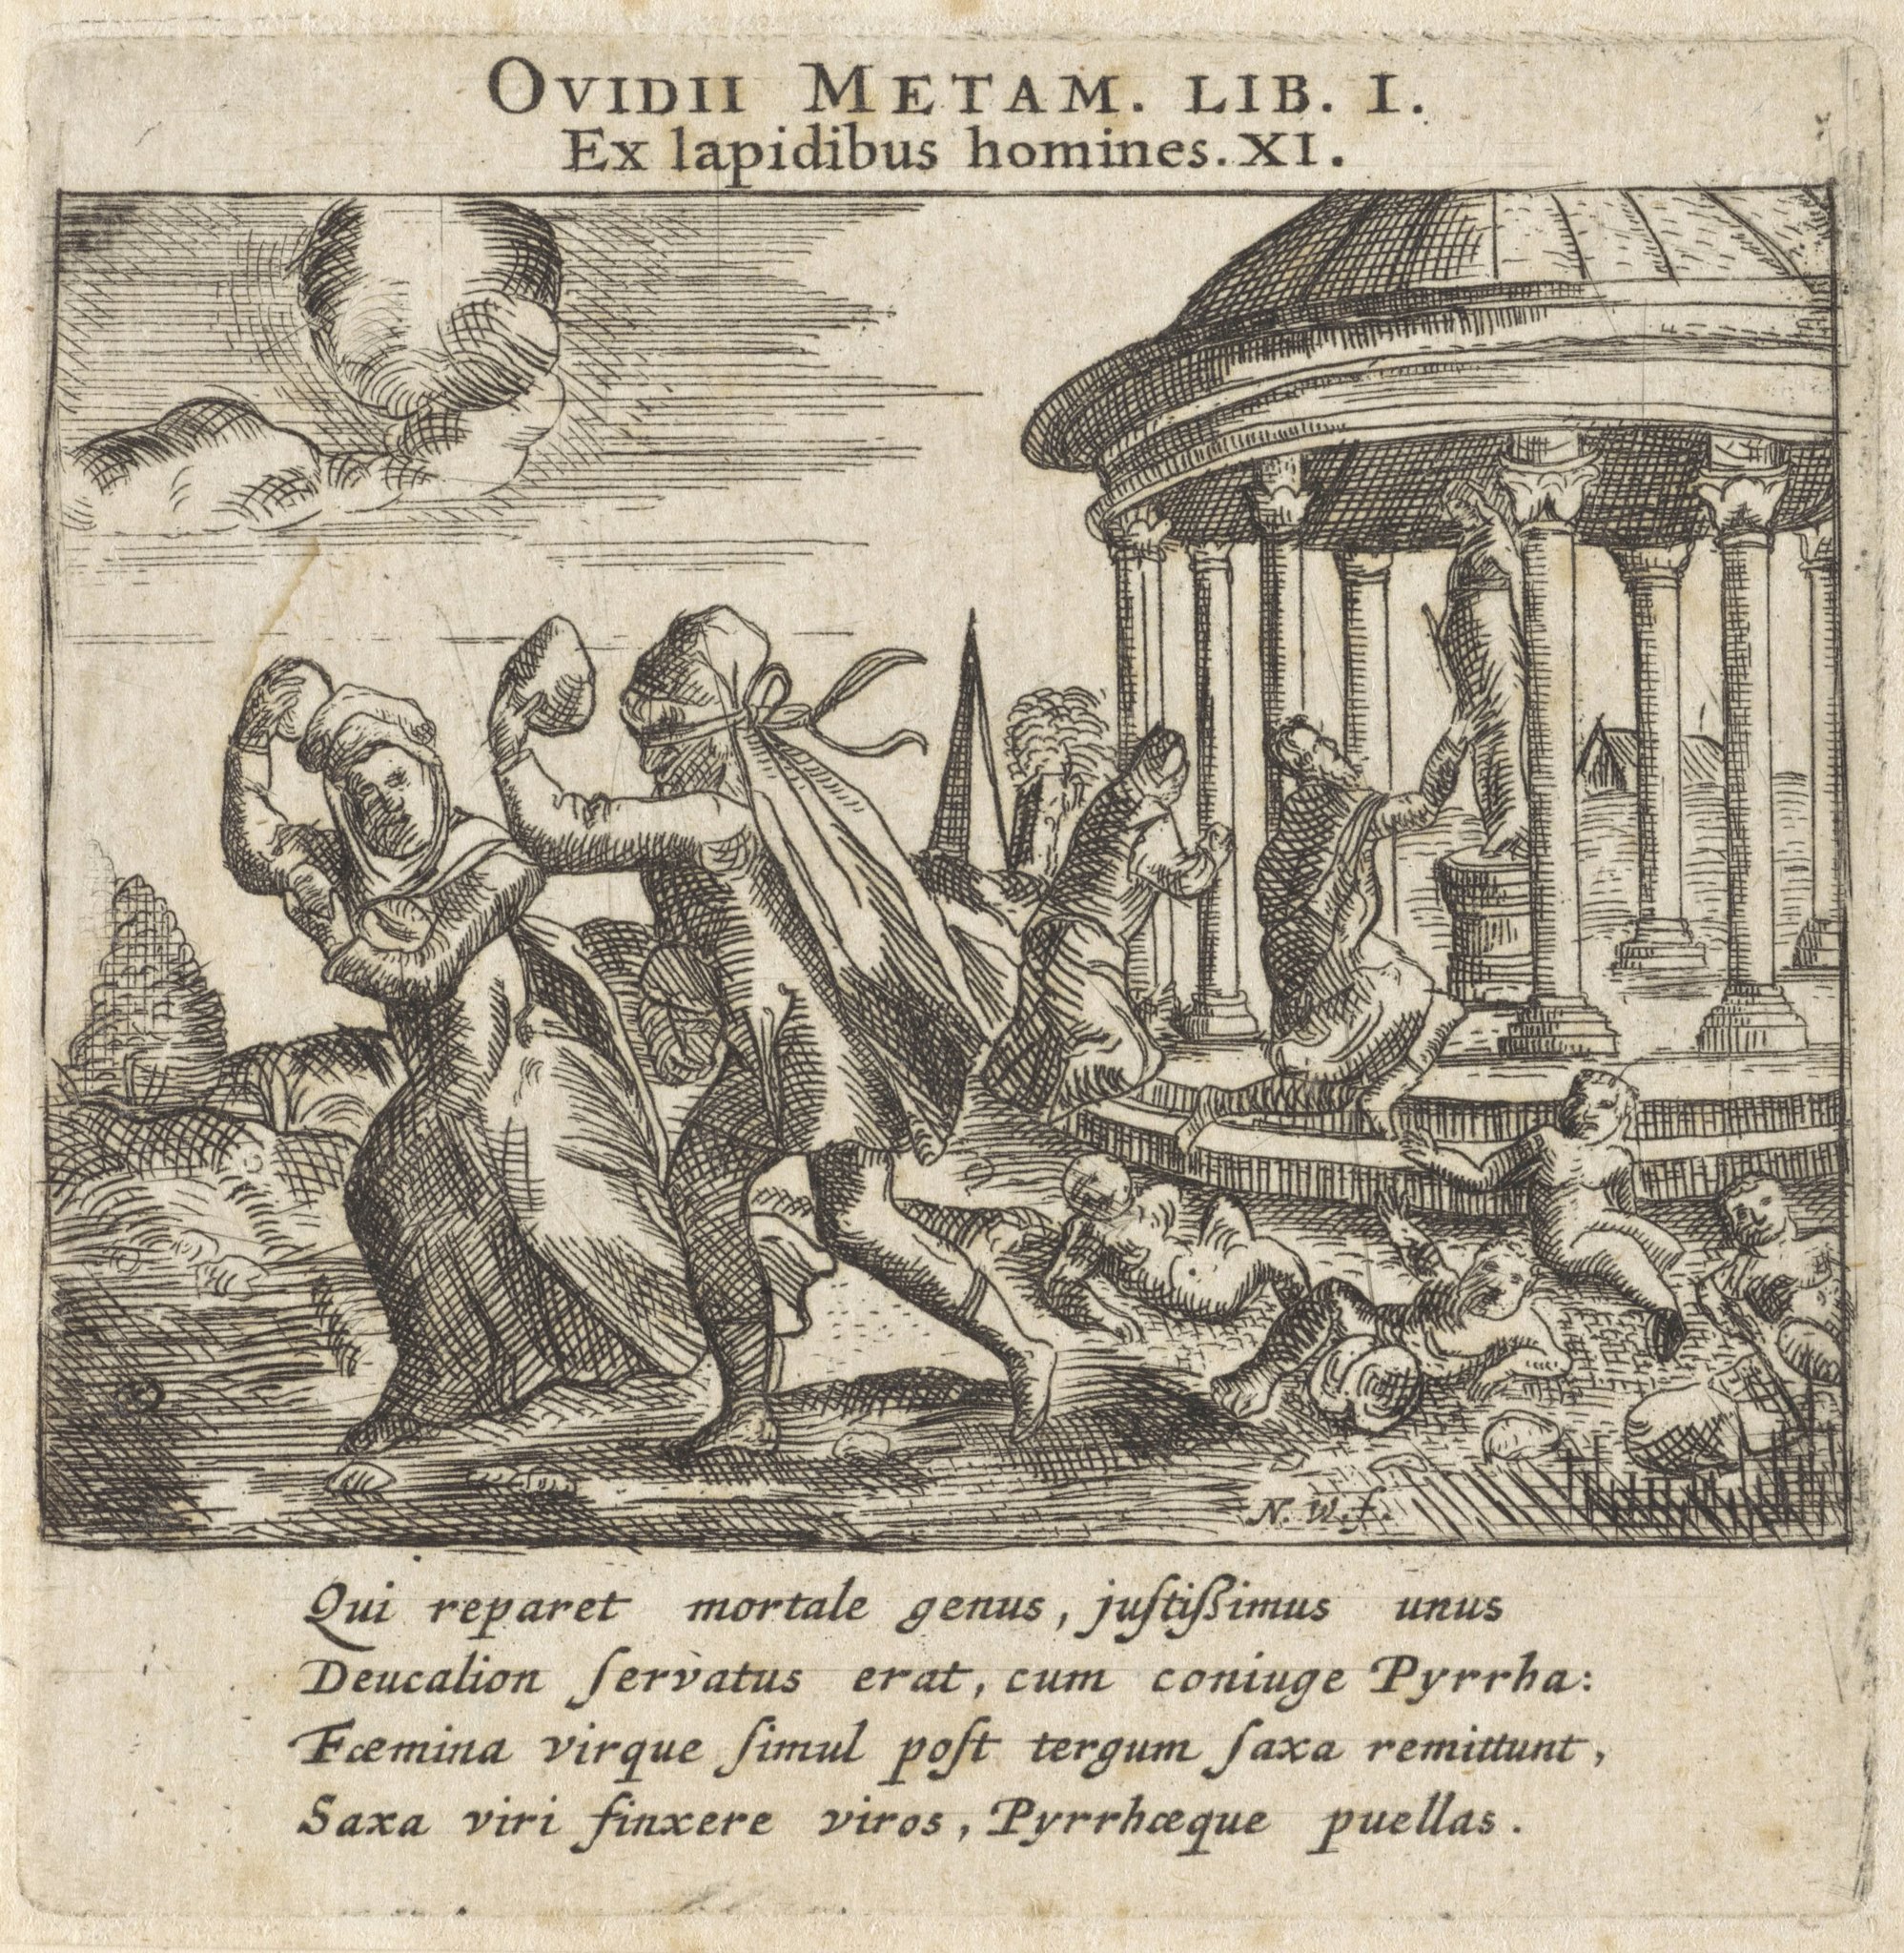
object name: print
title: Metamorphoseos liber primus (...)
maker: nicolaes cornelisz. witsen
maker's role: mayor, print maker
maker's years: 1641-1717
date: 1659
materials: paper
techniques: etching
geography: amsterdam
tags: stones turning into men: stones thrown by deucalion and pyrrha, as directed by the oracle of themis, turn into men (ovid, metamorphoses x 400)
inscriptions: collector's mark: Lugt 2165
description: Deucalion en Pyrrha gooien met gesluierde gezichten stenen over hun schouder, die in overeind krabbelende mannen en vrouwen veranderen. Achter deze scène staan ze bij de tempel van het orakel. Onder de voorstelling een vierregelige toelichting in het Latijn.